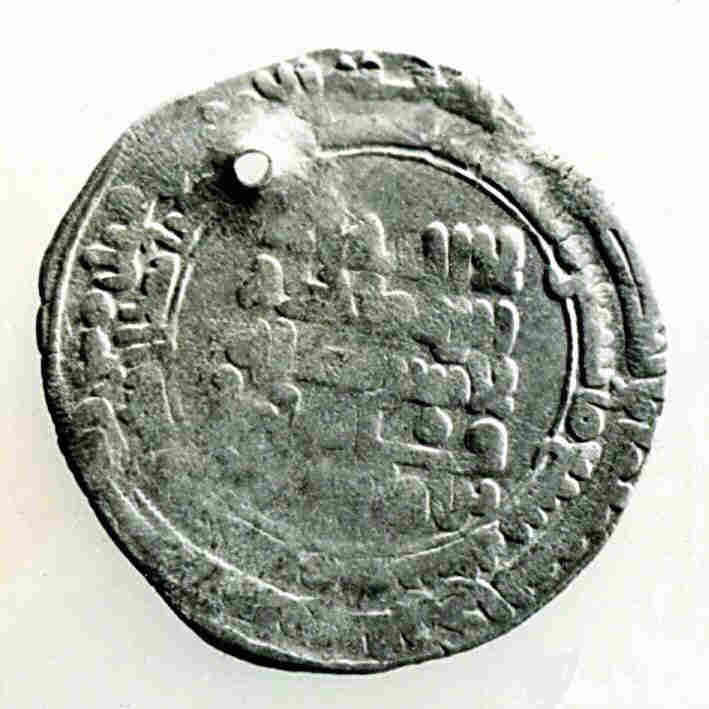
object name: coin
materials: silver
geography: jurjan